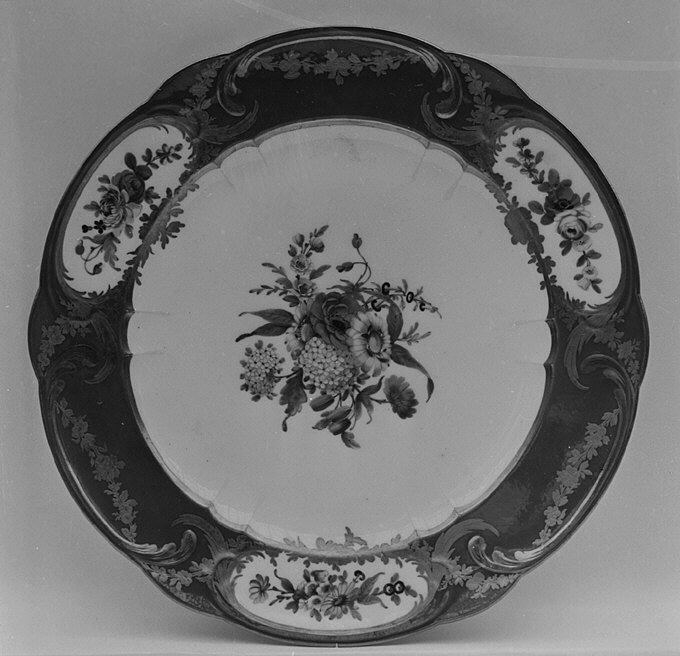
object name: plate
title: Plate (assiette à palmes) (1 of 102) (part of a service)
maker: sèvres manufactory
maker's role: manufactory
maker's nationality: french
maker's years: 1740-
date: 1780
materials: soft paste porcelain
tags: flowers